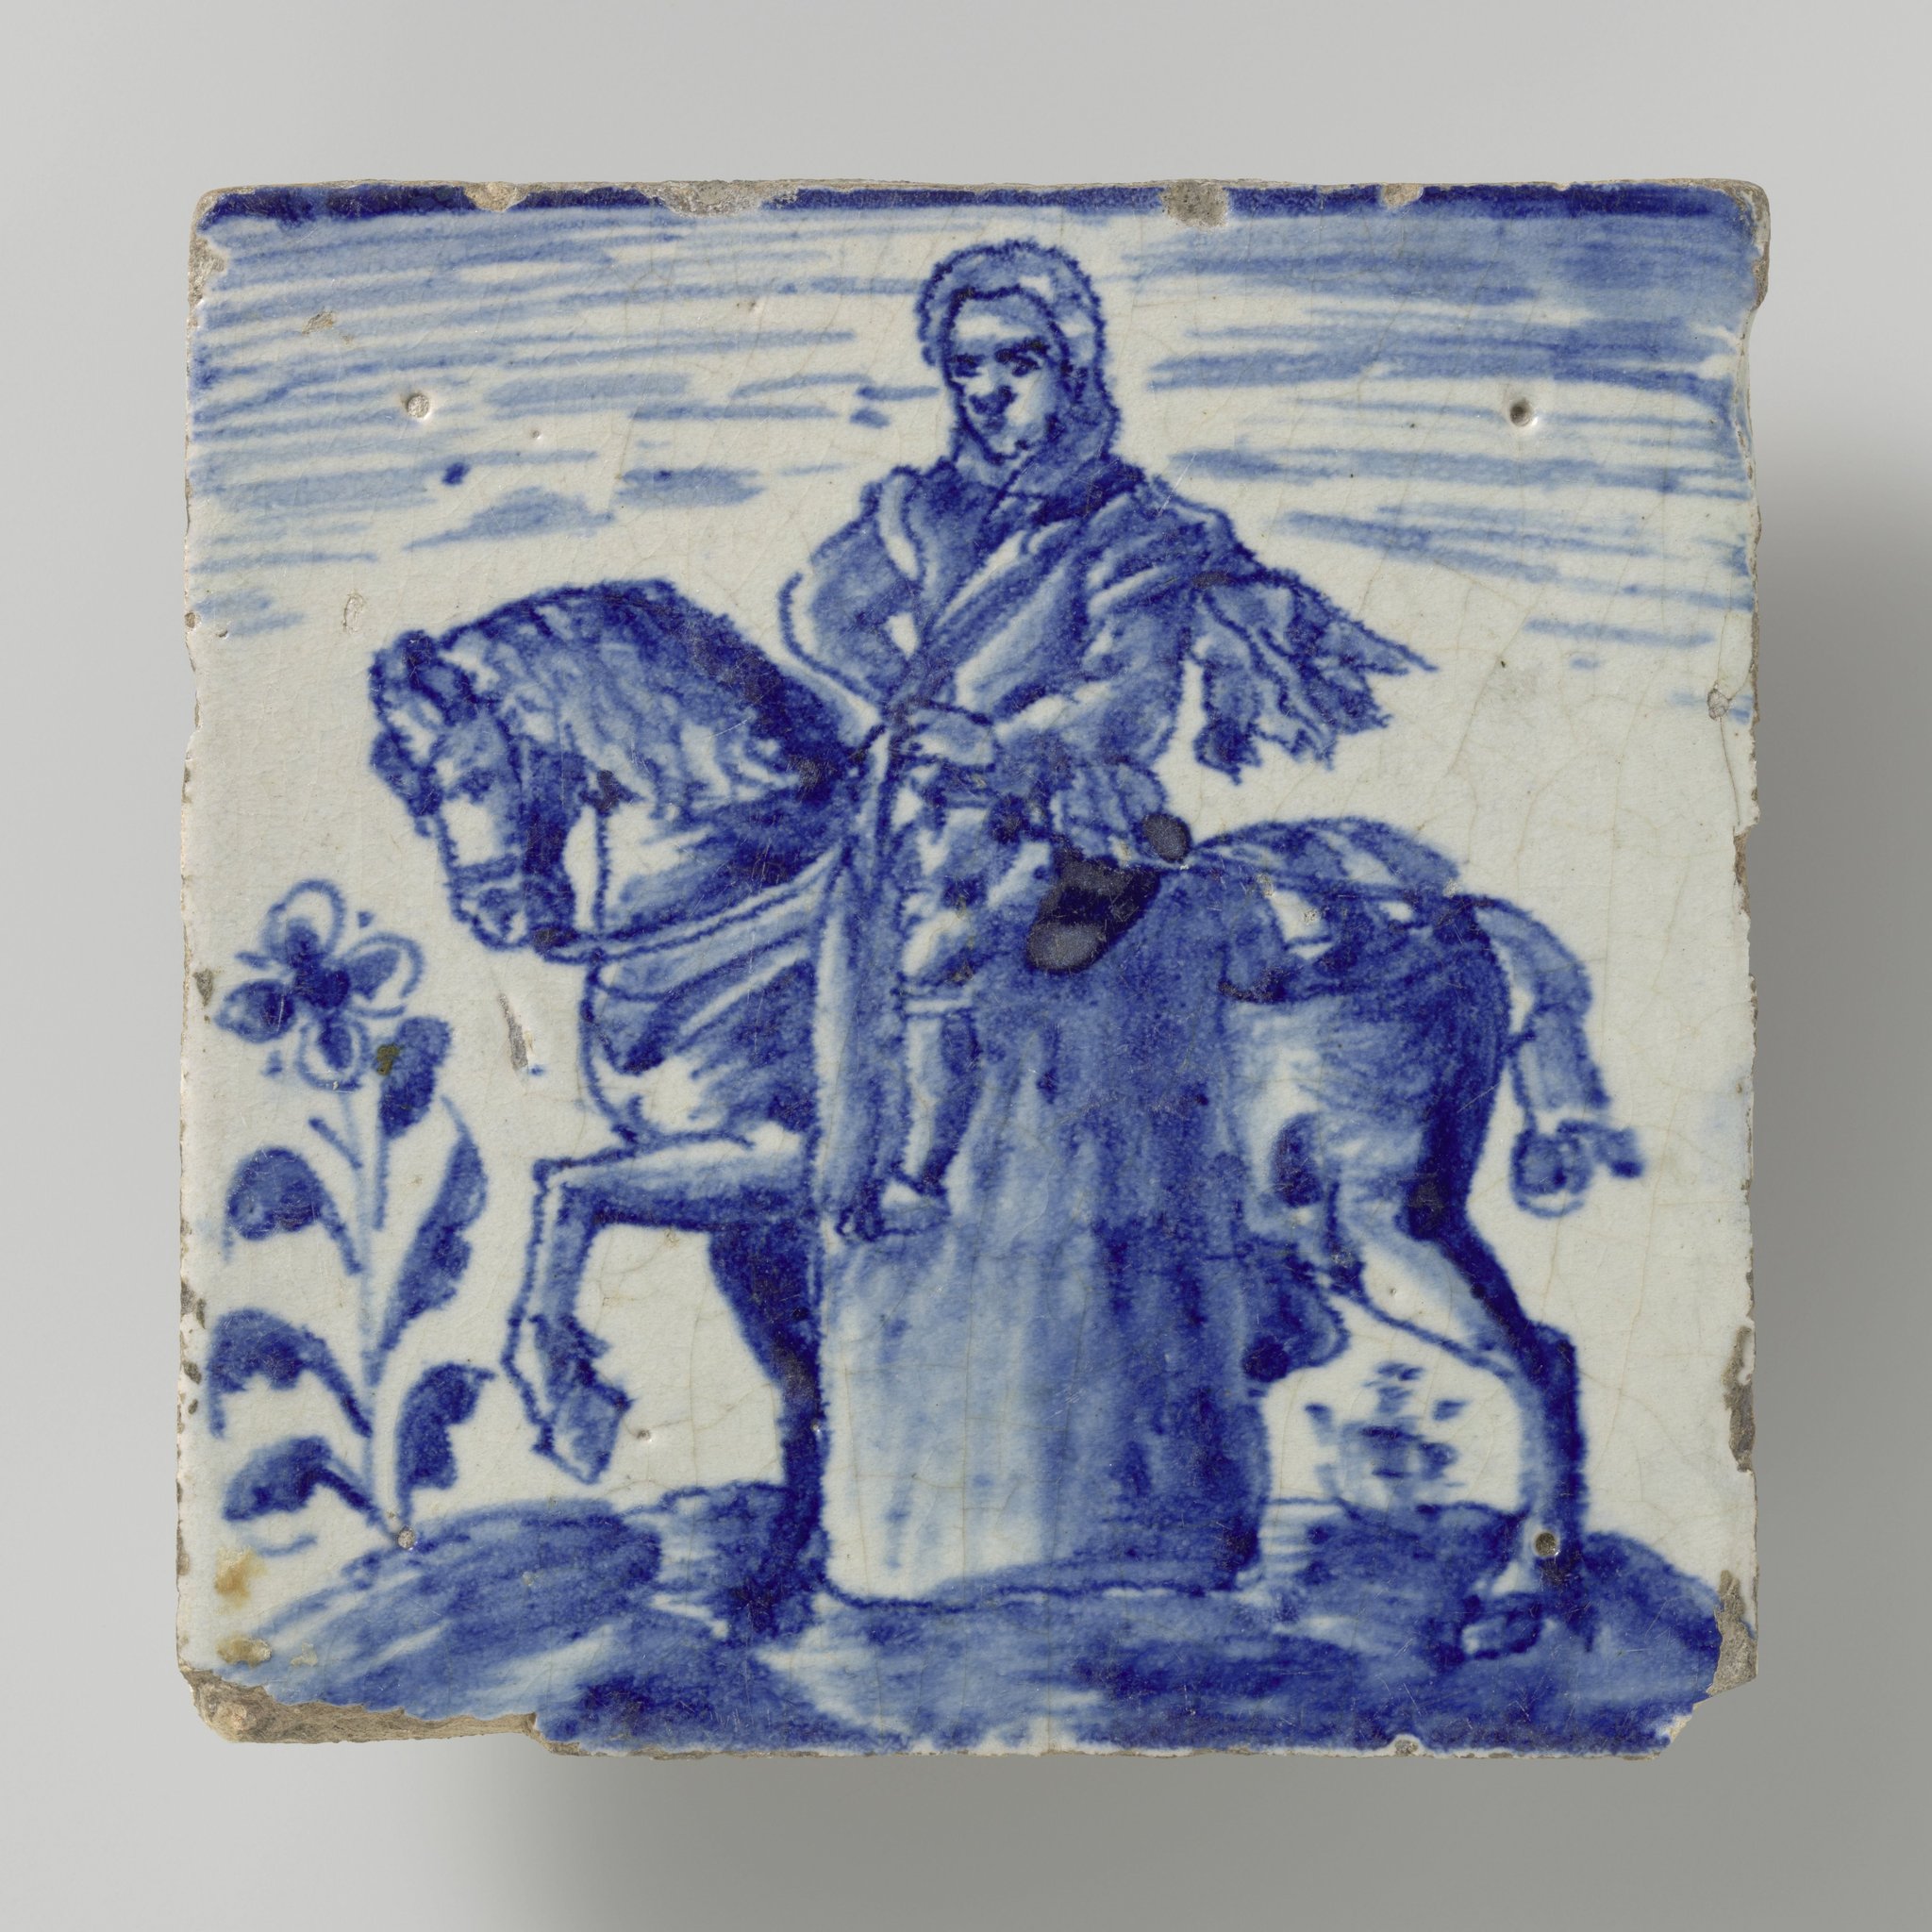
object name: ruitertegel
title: Tegel met ruiter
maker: Anonymous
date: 1580-1625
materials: earthenware, glaze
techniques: maiolica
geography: netherlands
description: Tegel met een blauw geschilderde ruiter op een grond.